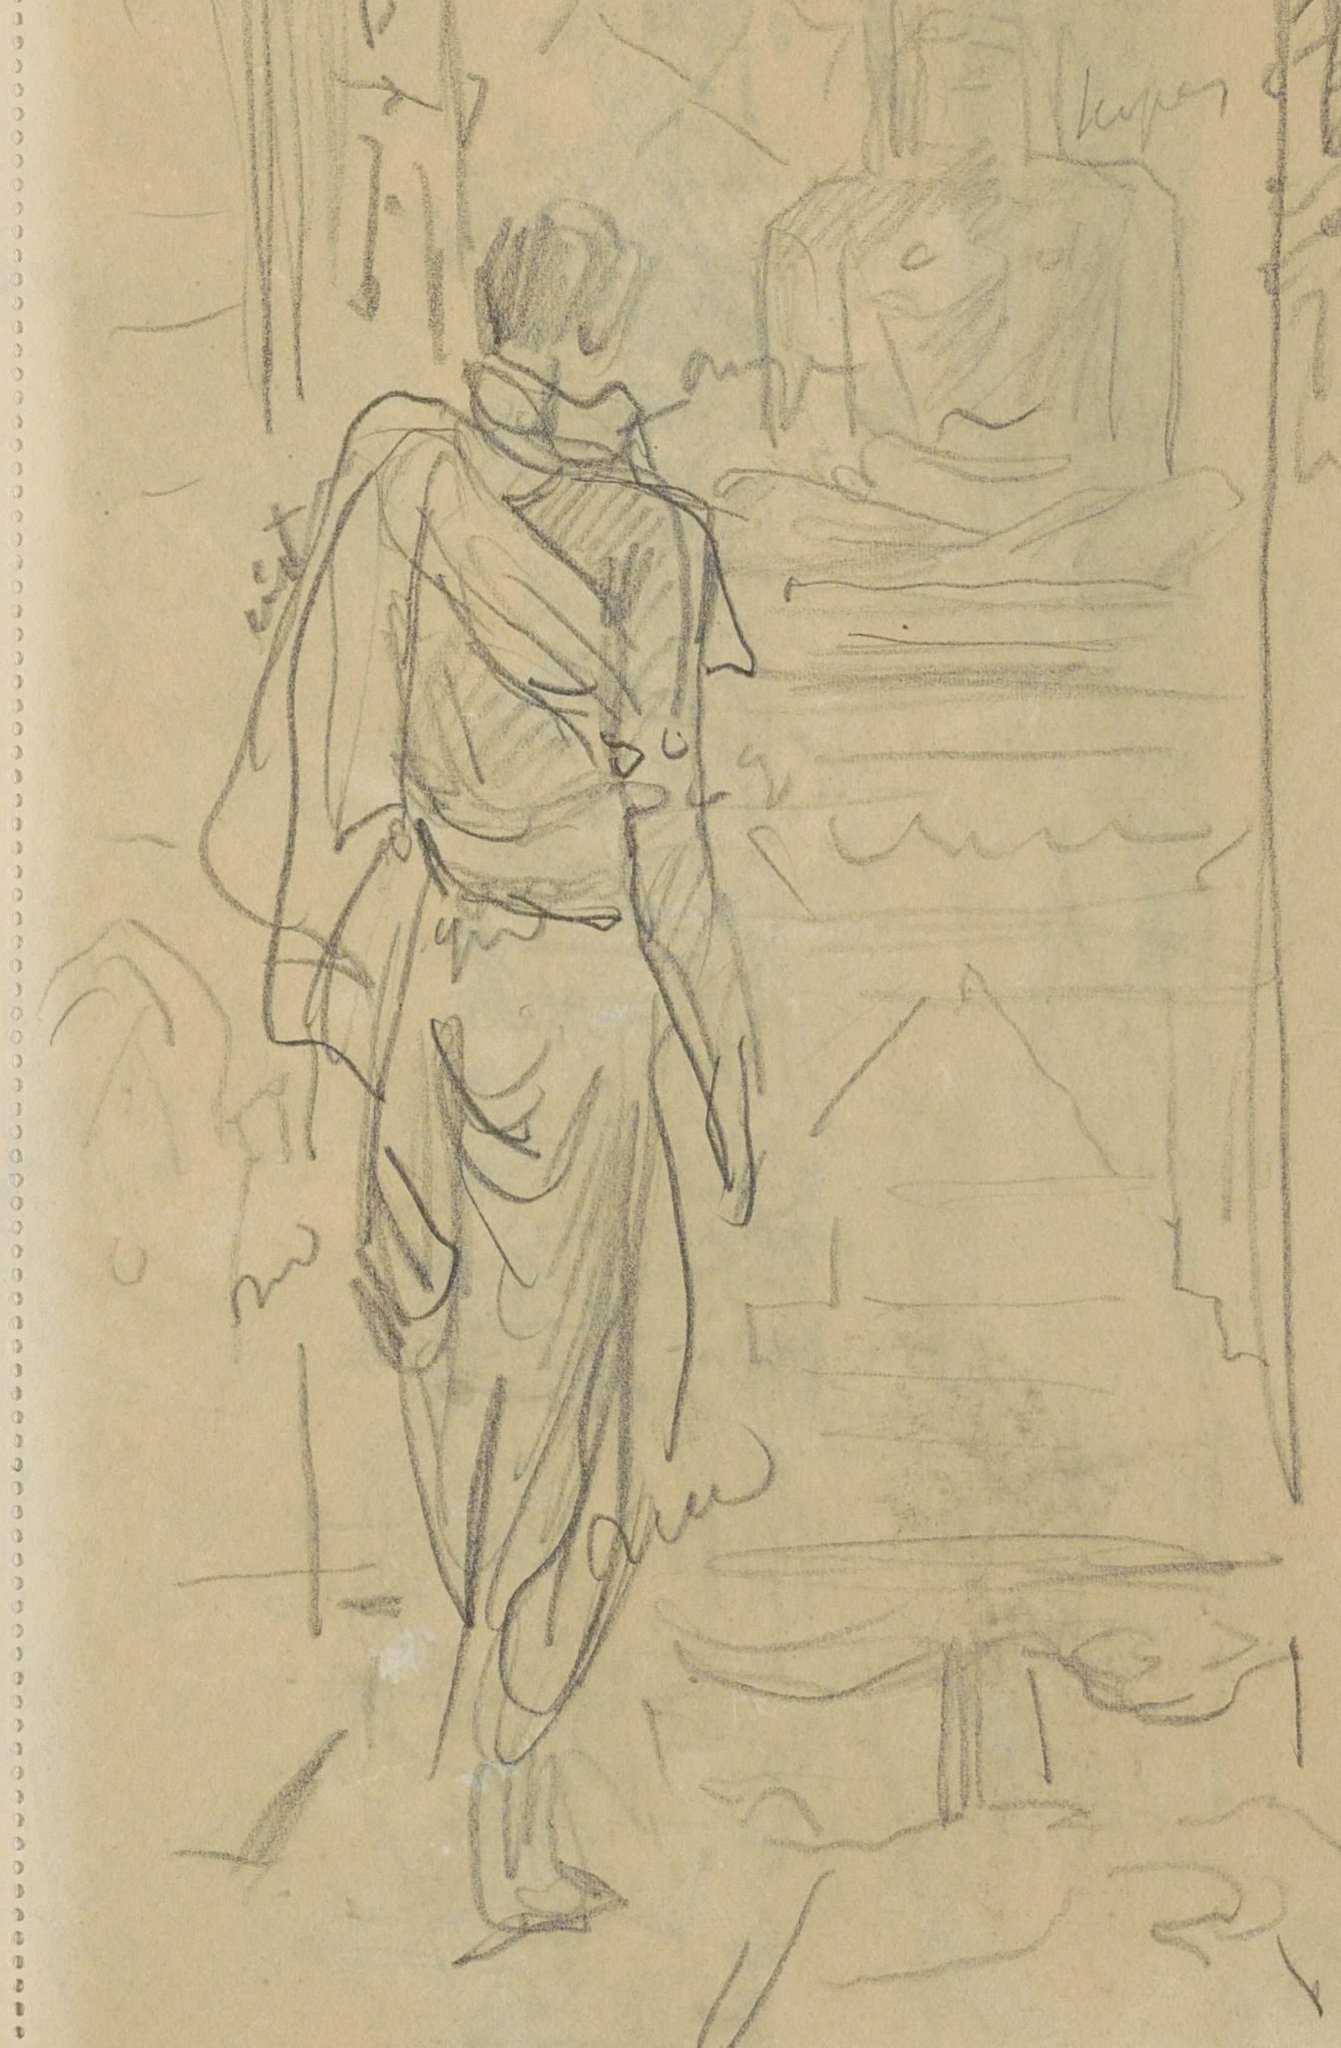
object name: sketchbook leaf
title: Indiër voor een beeld van een Hindoeïstische god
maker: marius bauer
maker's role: draughtsman, print maker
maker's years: 1867-1932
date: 1924-1925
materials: paper, pencil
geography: india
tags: places and objects of worship ~ hinduism, buddhism, jainism, asiatic races and peoples: indians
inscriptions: kleurnotitie, handgeschreven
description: Mogelijk staat de figuur in een tempel. Pagina 3 uit een schetsboek met 87 bladen.